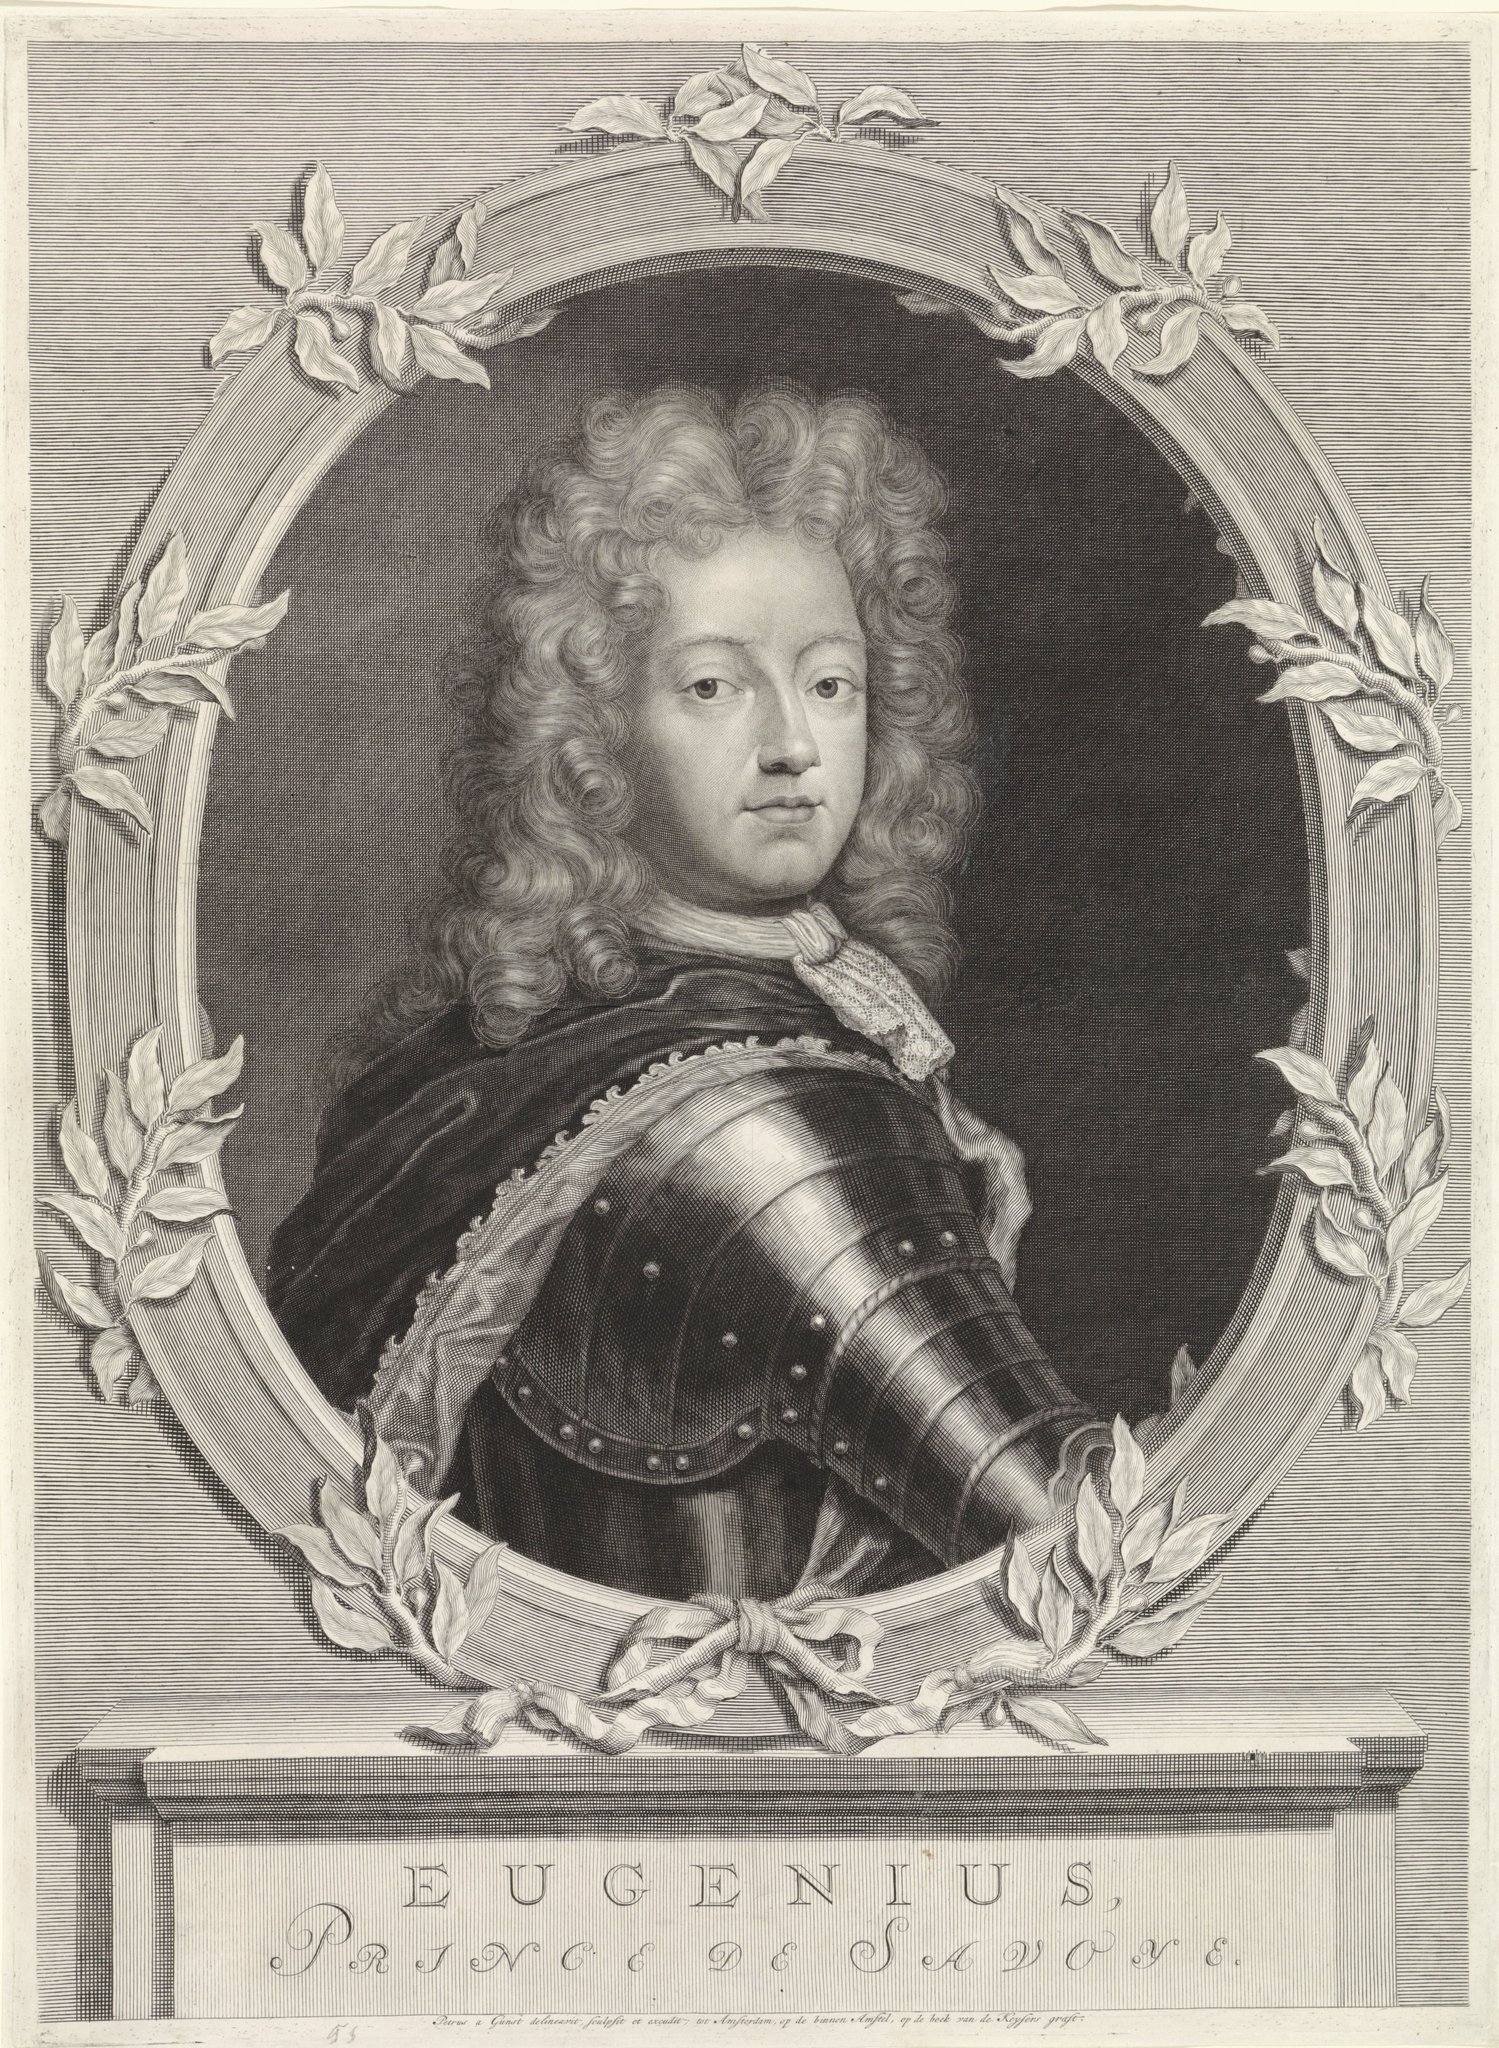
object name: print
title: Portret van prins Eugenius van Savoye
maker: pieter van gunst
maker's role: print maker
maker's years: 1658-1731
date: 1681-1731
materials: paper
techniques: engraving, etching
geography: amsterdam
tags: vienna, eugenius van savoye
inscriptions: collector's mark: Lugt 2228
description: Eugenius, prins van Savoye en generaal van Oostenrijk tijdens de Spaanse successieoorlog.